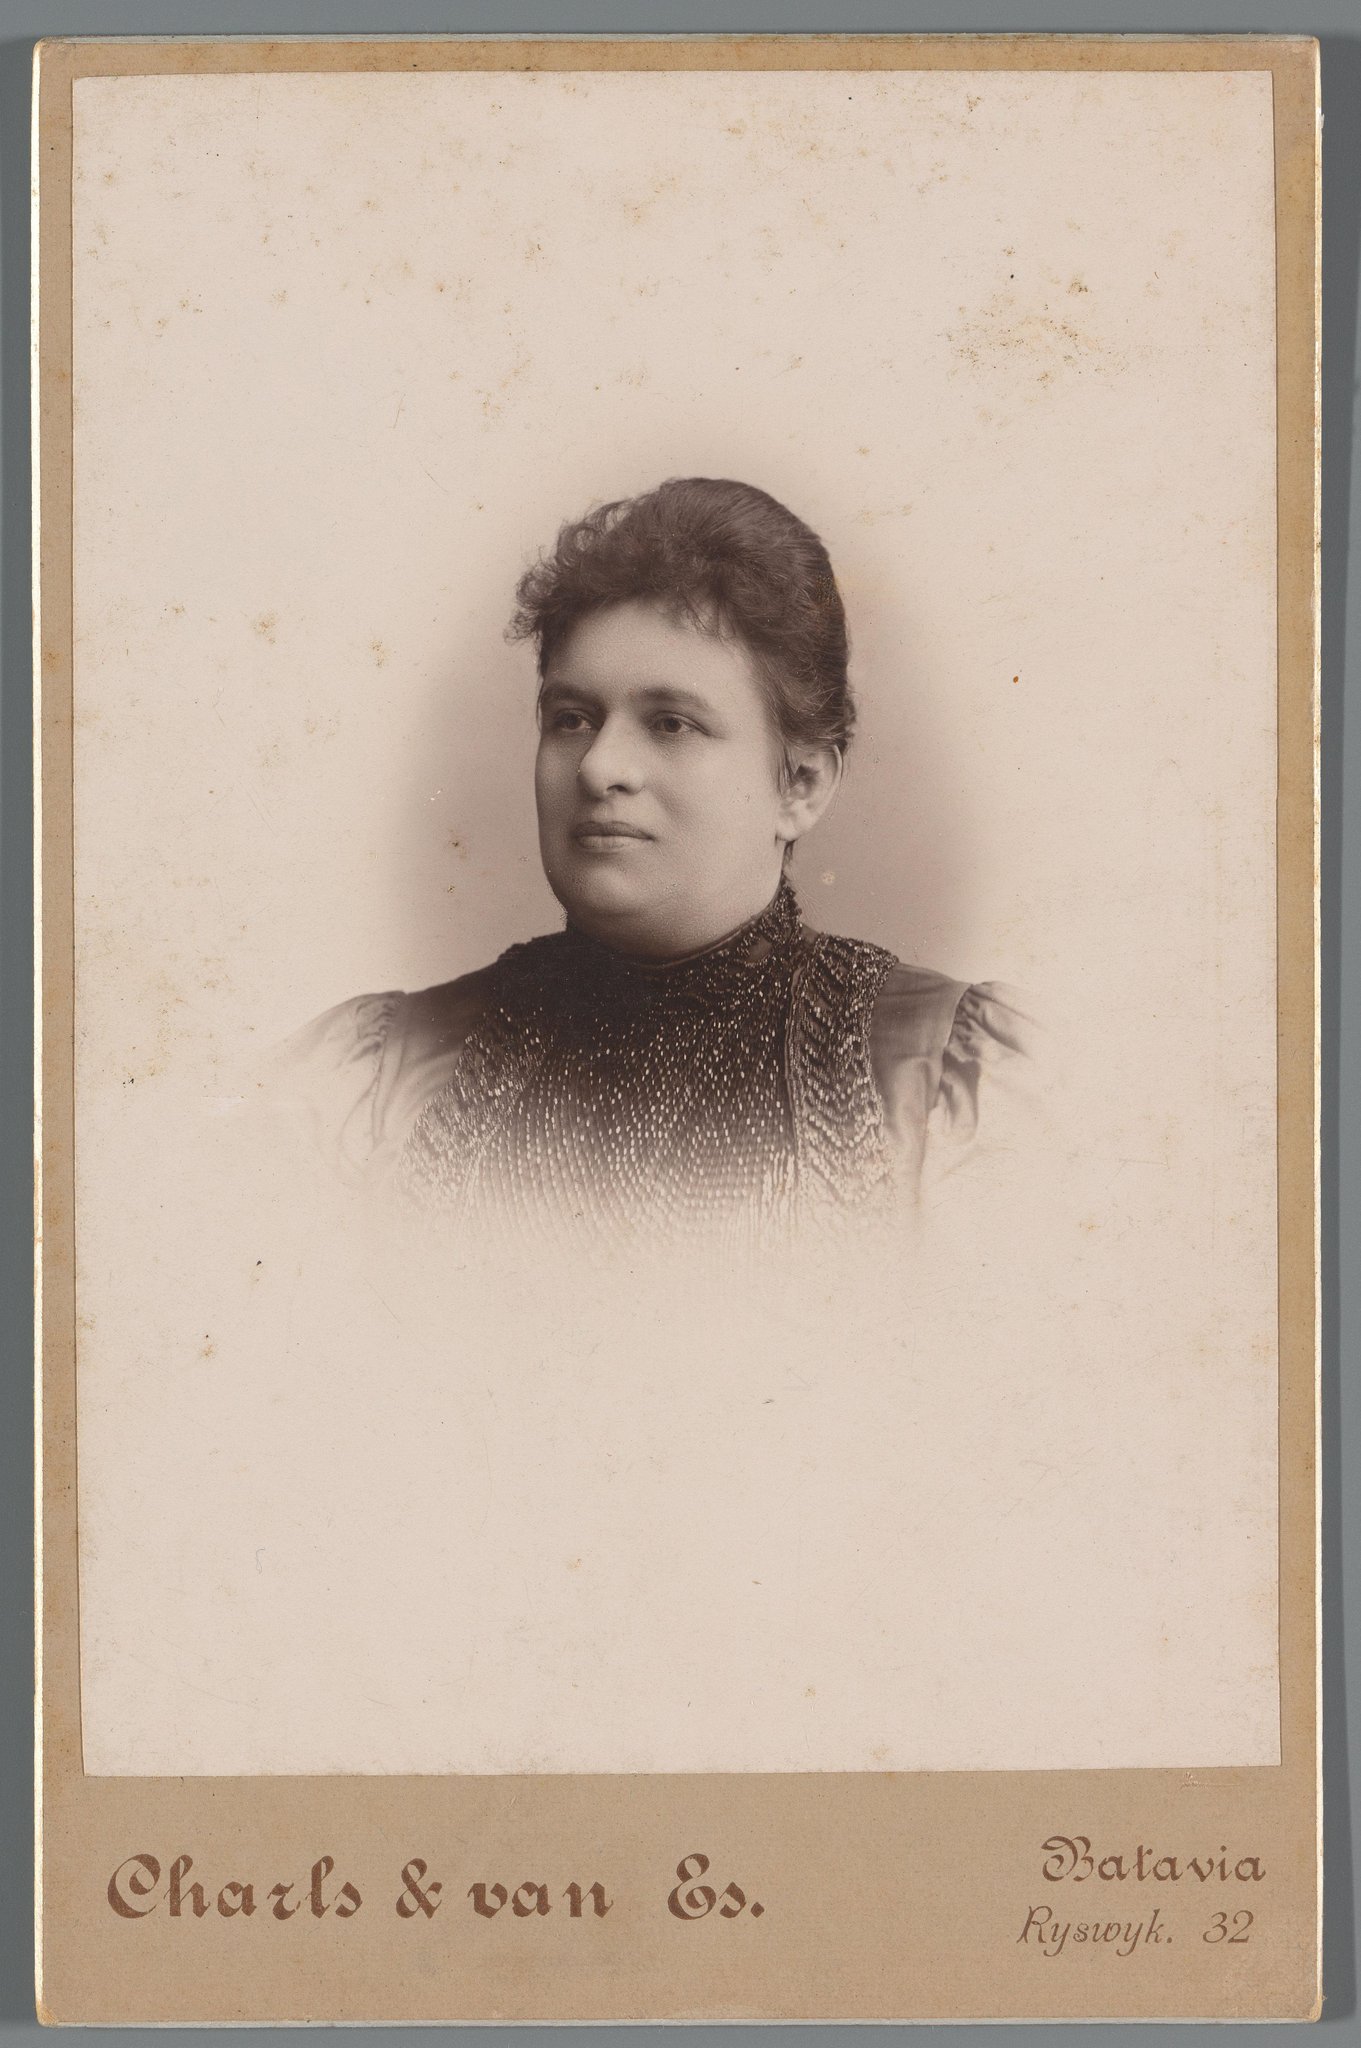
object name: cabinet photograph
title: Studioportret van Françoise van den Berg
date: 1895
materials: cardboard, photographic support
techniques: albumen print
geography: batavia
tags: francina schas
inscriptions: name: ‘Charls & van Es. Batavia / Ryswyk. 32’, inscription: ‘aan ... vriend / Dr Gutteling / Françoise v.d. Berg / Schas / Batavia 15 Juni 95’